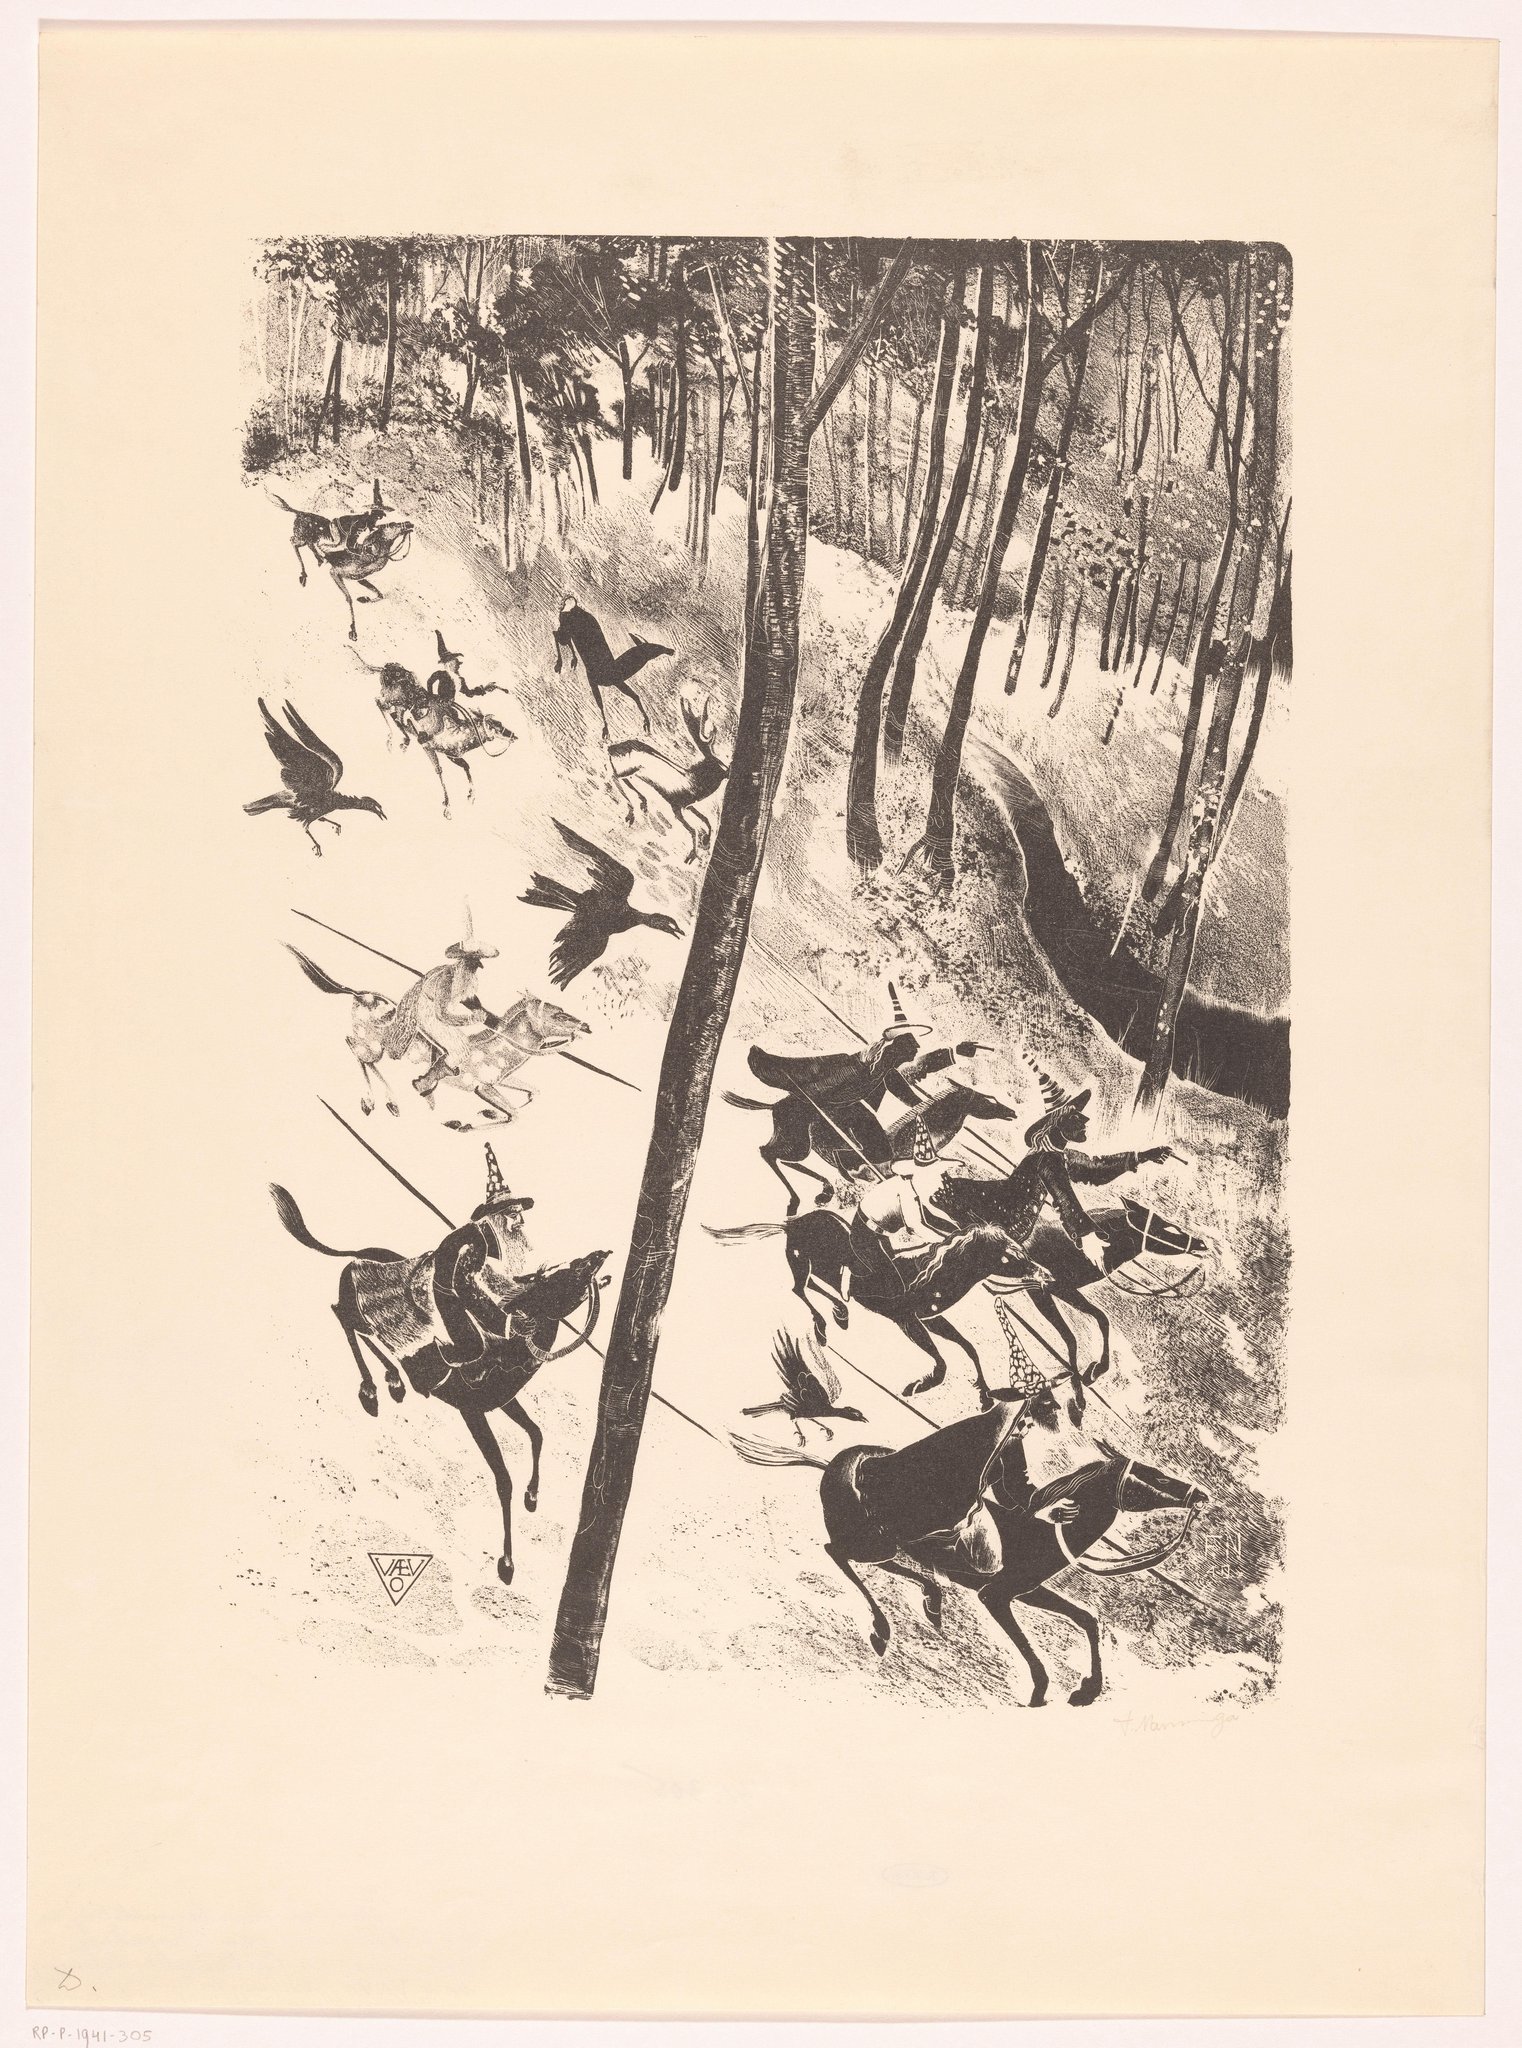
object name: print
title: Ruiterstoet in bos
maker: dirk berend nanninga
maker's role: print maker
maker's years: 1868-1954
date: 1940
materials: paper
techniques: lithograph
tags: riding a horse, ass, or mule; rider, horseman, sorcerer, magician, wizard, warlock, forest, wood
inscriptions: collector's mark: Lugt 2228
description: Acht ruiters met tovenaarshoeden op galopperen door een bos. Drie vogels en twee herten trekken met de stoet op. Linksonder het logo van de Vereniging tot bevordering van het Aesthetisch Element in het Voortgezet Onderwijs (V.AE.V.O.).